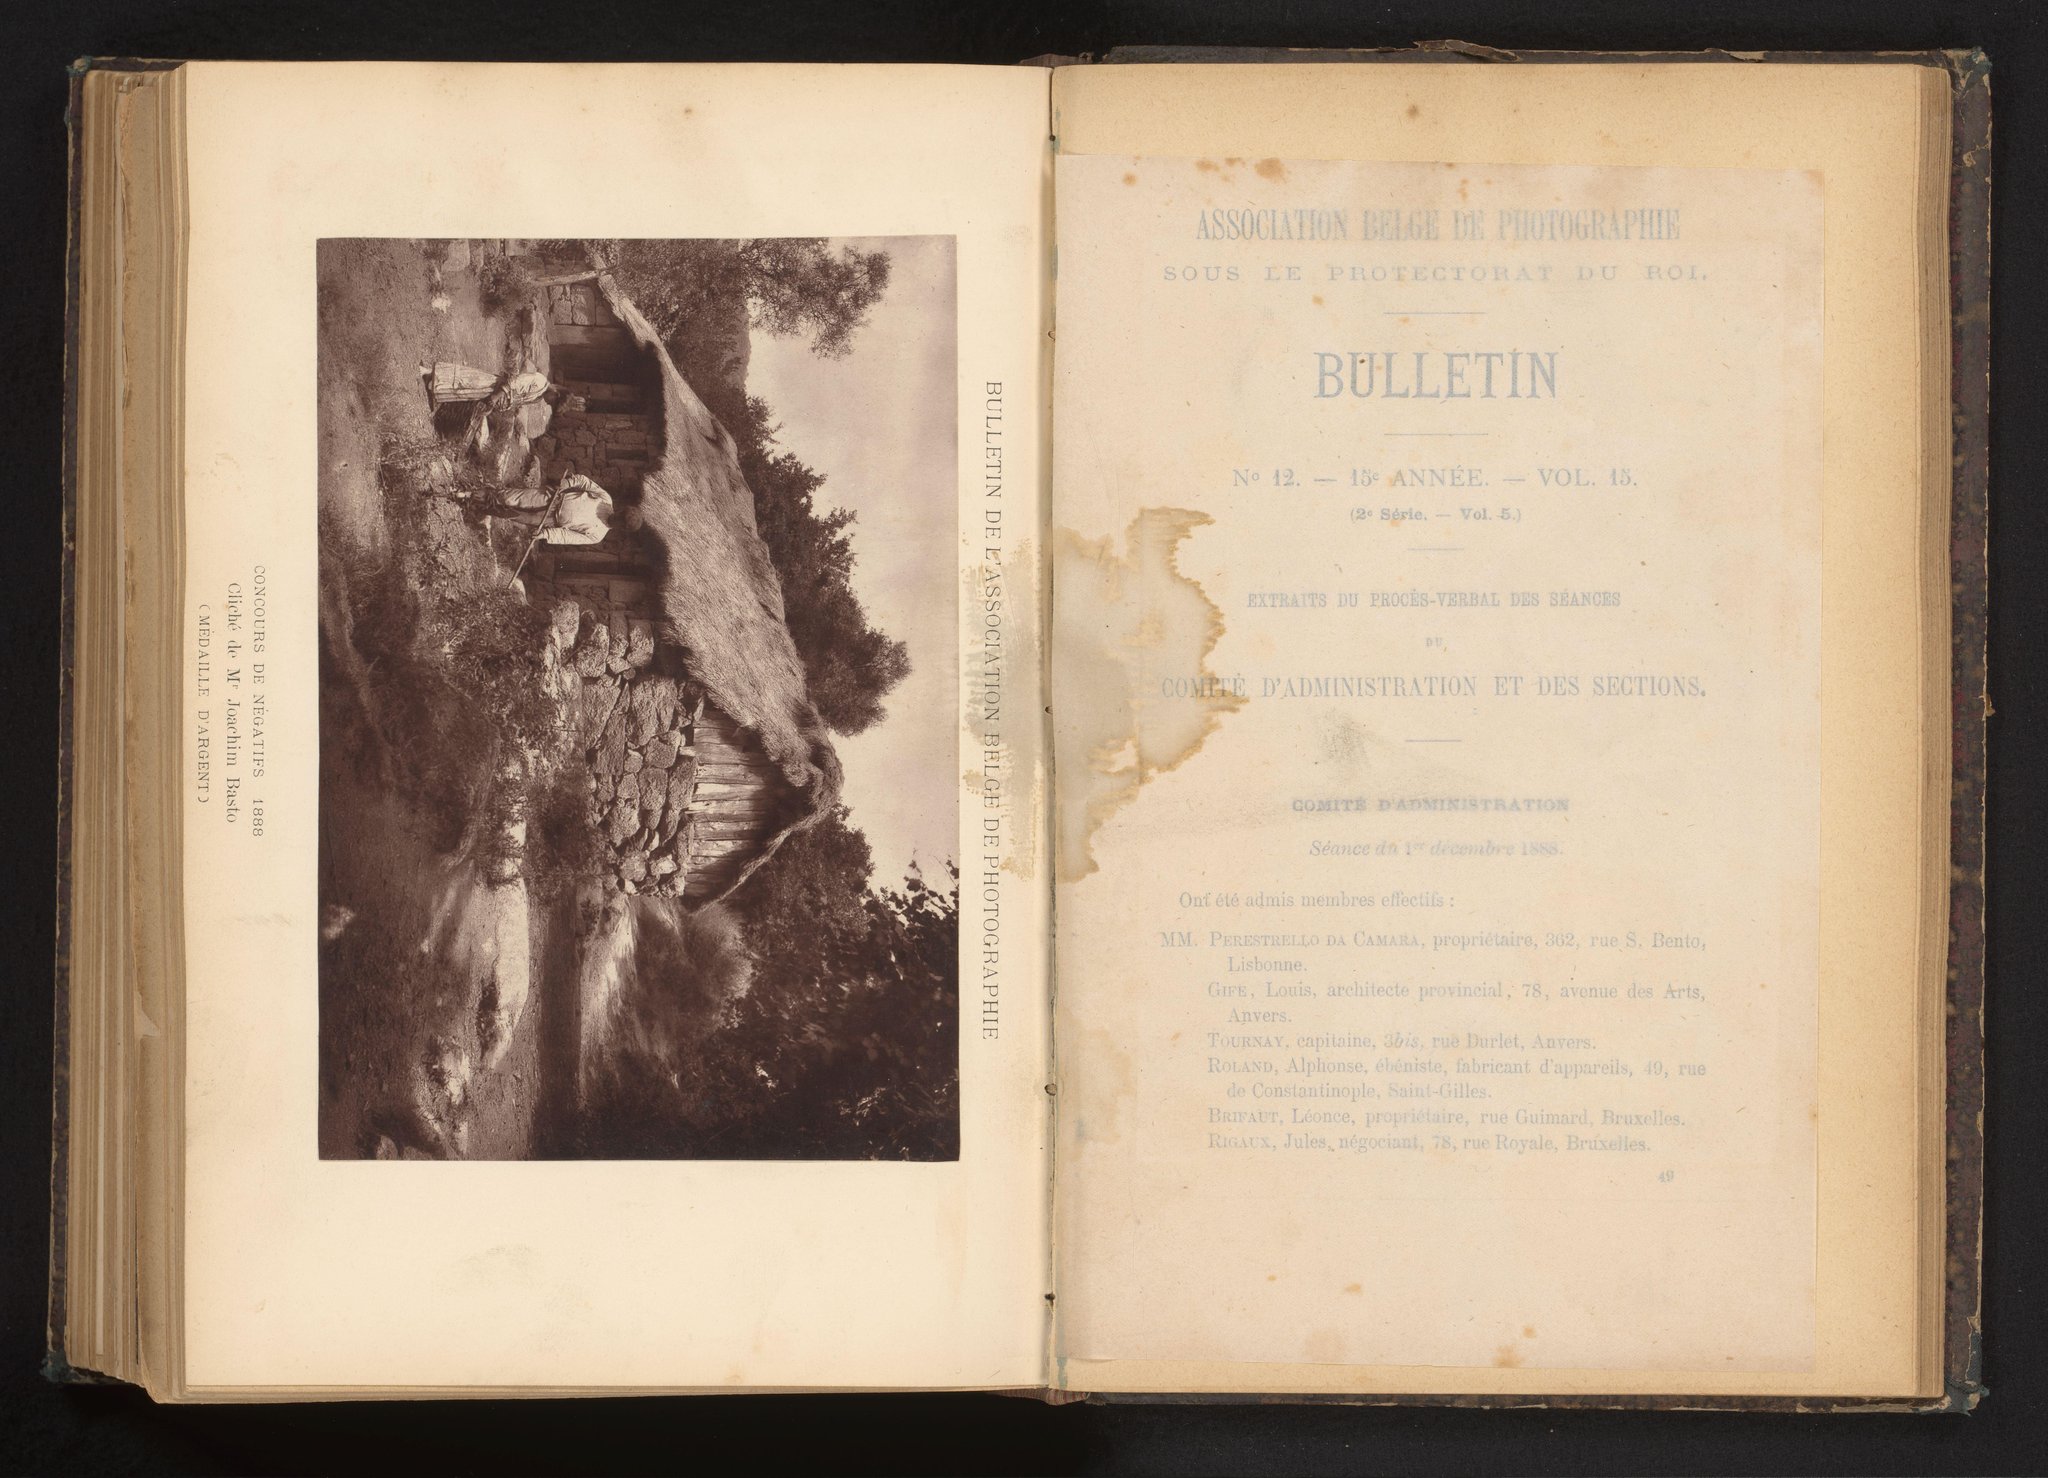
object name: photomechanical print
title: Onbekende man en meisje bij een woning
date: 1883-1888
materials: paper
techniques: woodburytype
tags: historical persons, housing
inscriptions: inscription: ‘Bulletin de l'association belge de photographie/ Concours de négatifs 1888. (Médaille d'Argent)’